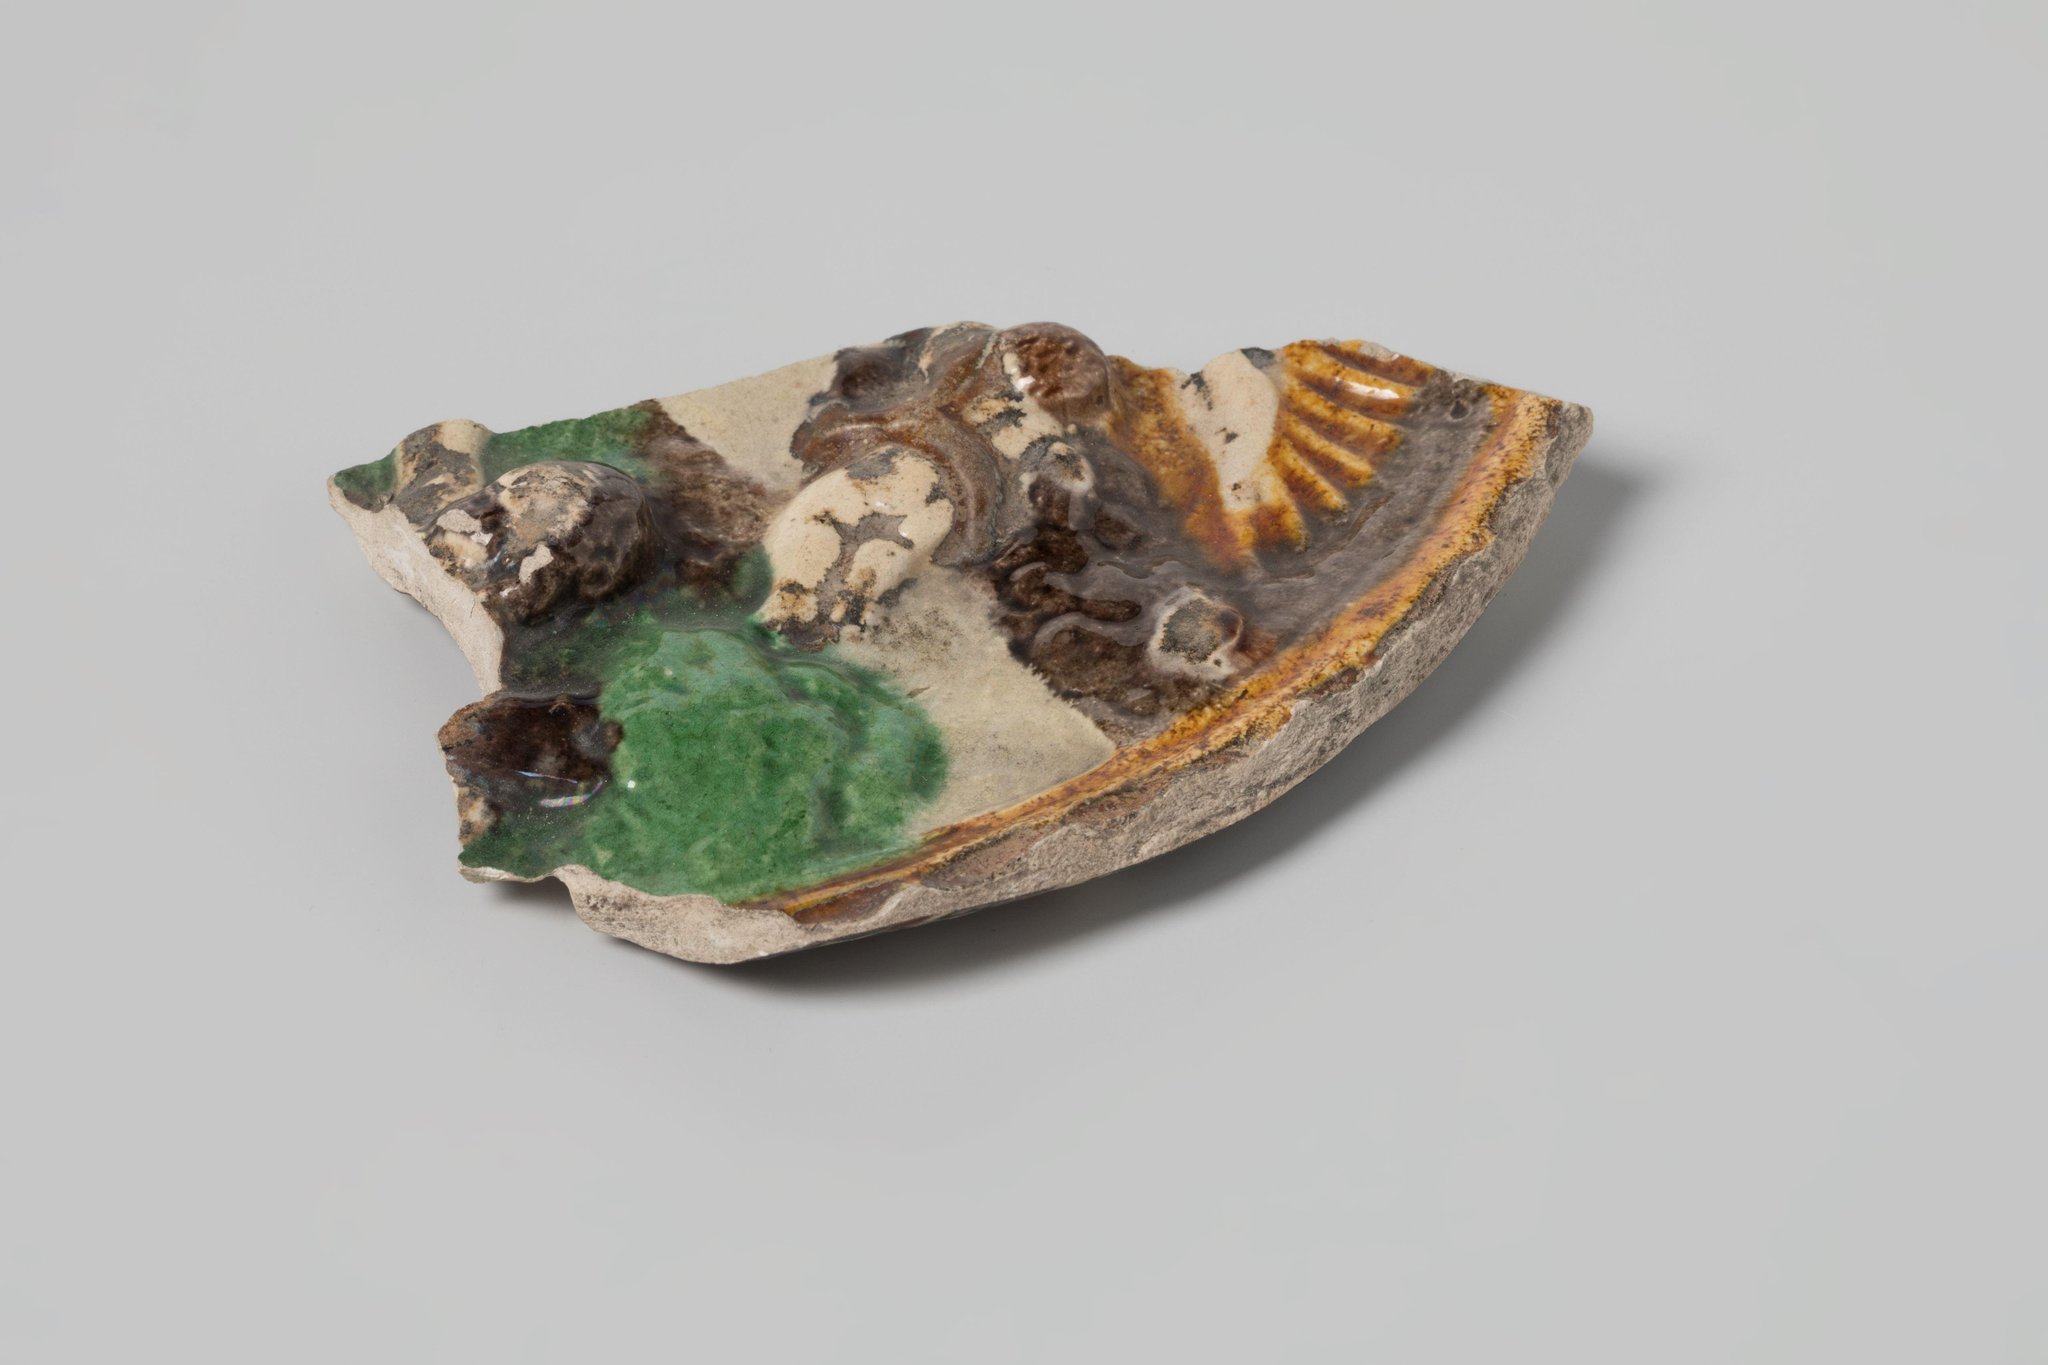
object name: sherd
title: Schotelscherf van aardewerk, voorzien van glazuren in verschillende kleuren en en in reliëf mogelijk een religieuze voorstelling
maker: Anonymous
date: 1500-1799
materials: earthenware, glaze